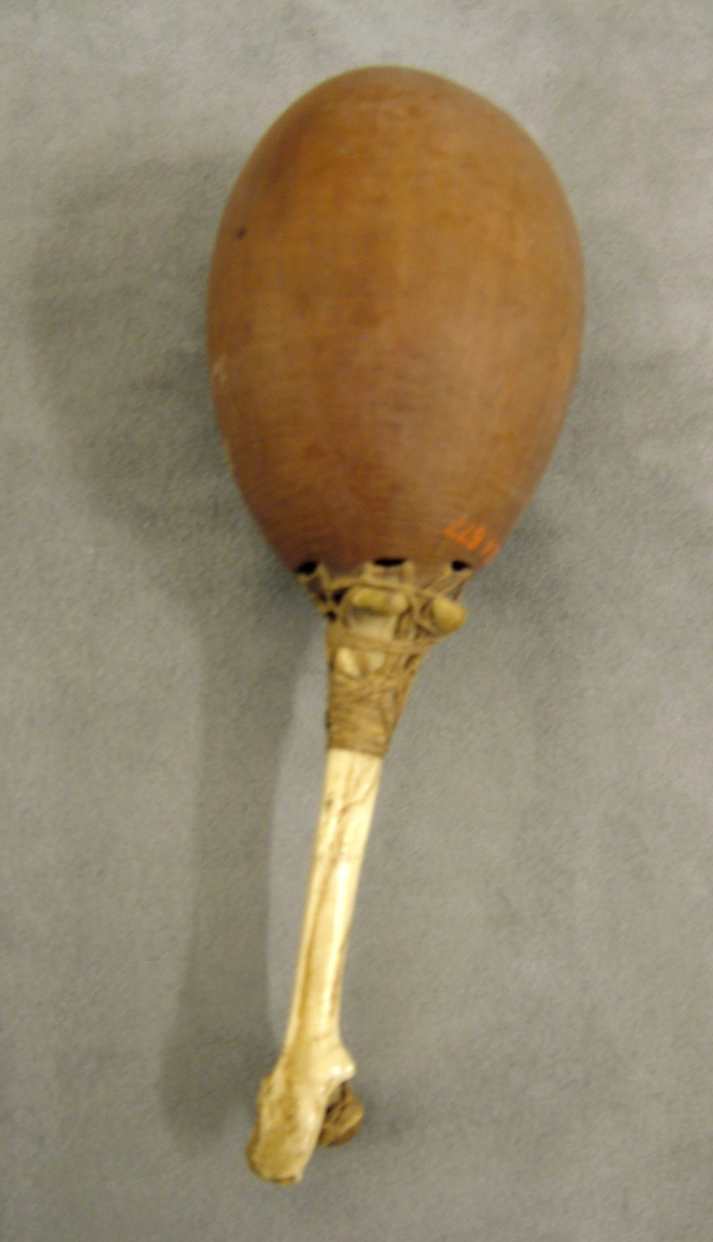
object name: rattle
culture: native american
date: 1873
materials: bone, cord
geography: costa rica